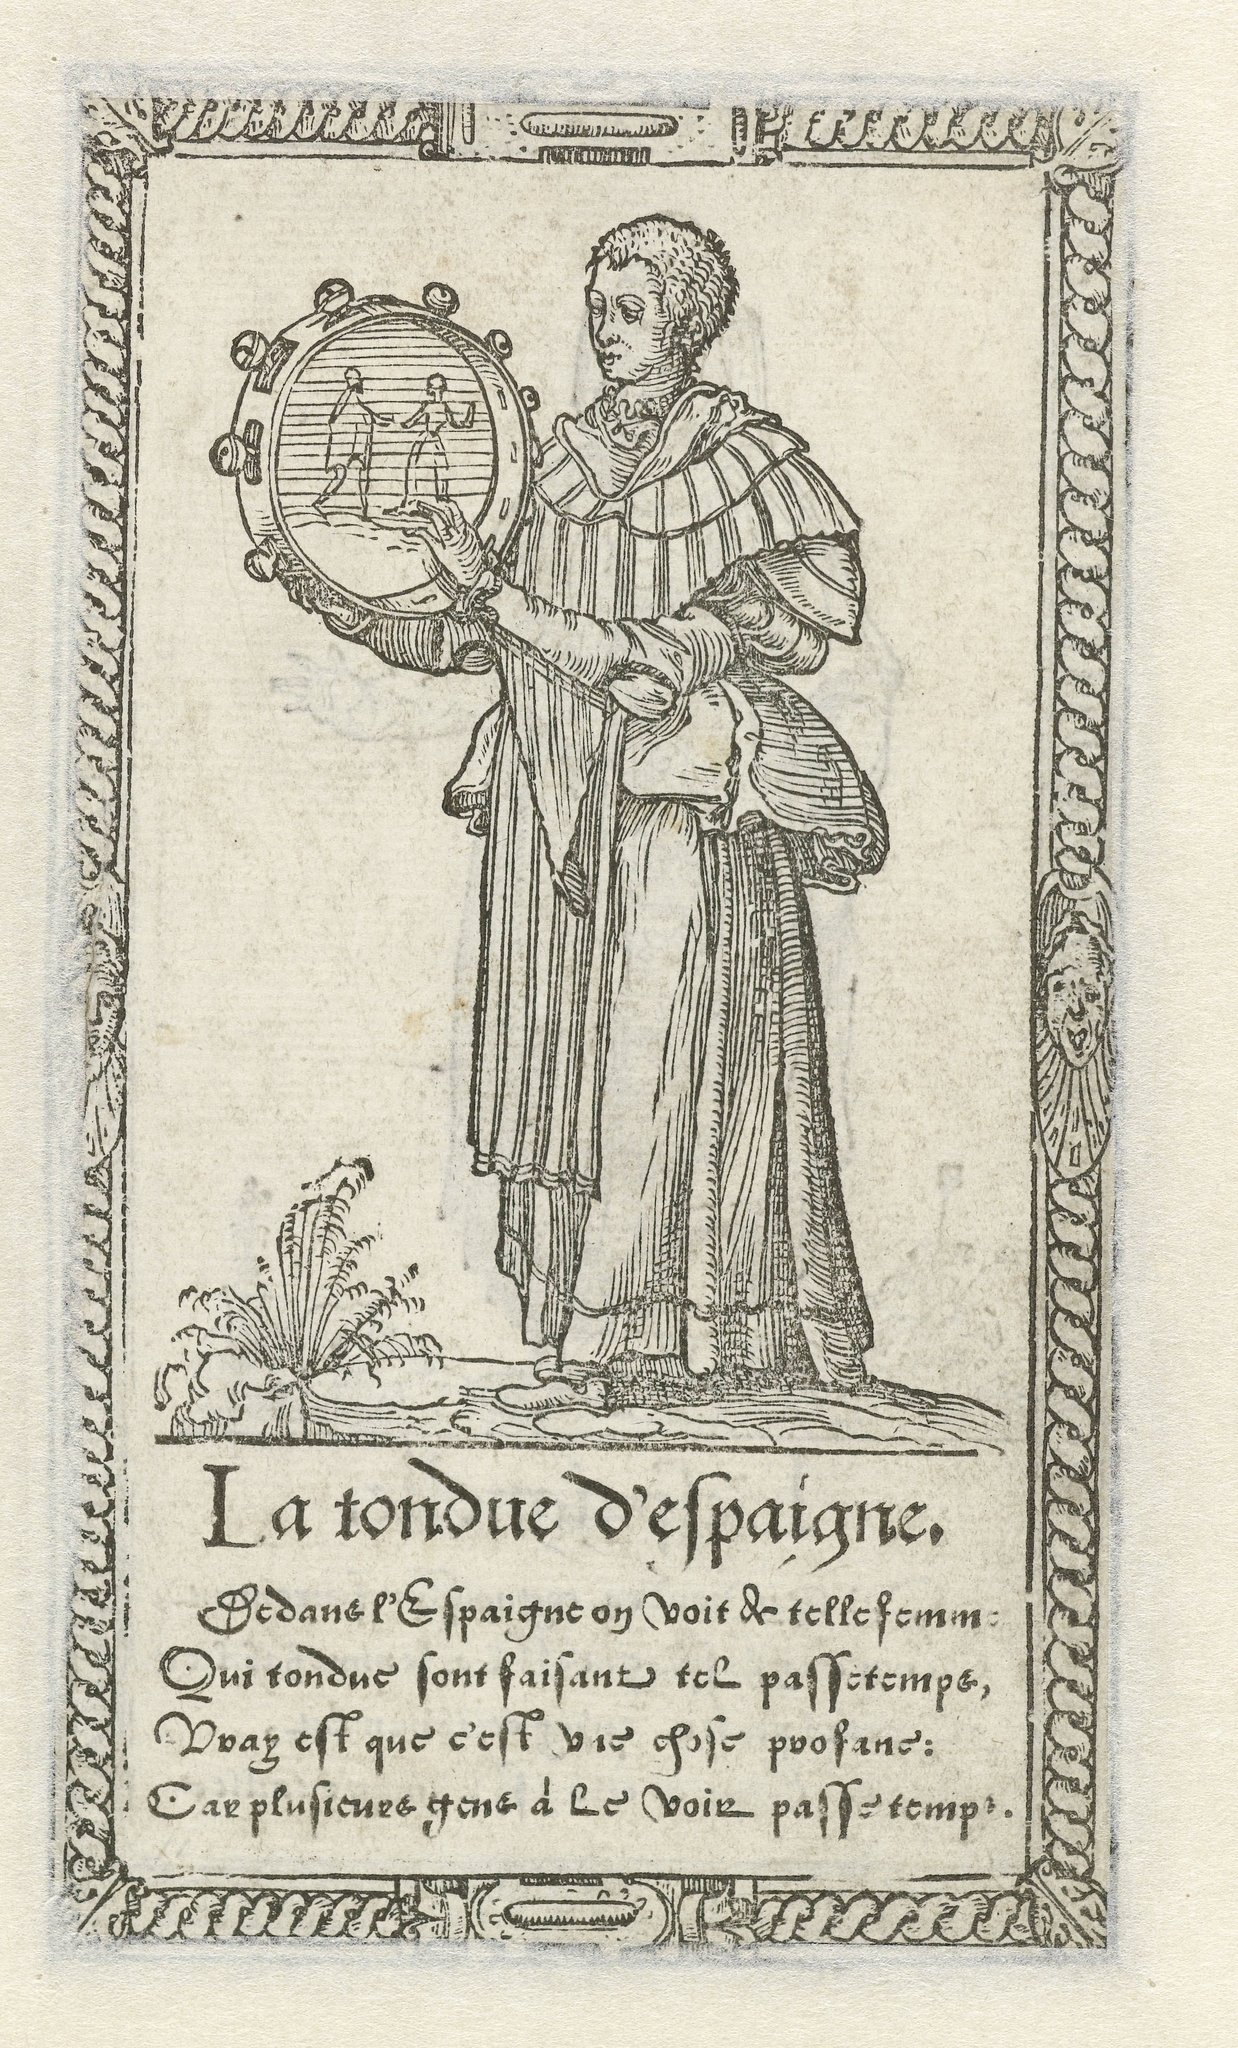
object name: print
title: Recueil de la diversité des habits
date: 1562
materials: paper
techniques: woodcut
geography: paris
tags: tambourine - cc - out of doors, europeans: spaniards (+ costume), fashion plates, folk costume, regional costume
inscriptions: collector's mark: Lugt 2228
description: Dit is prent 75 uit een serie van 121. Binnen deze serie zijn er prenten gemaakt naar voorbeelden van Jean-François de Roberval en Enea Vico, onbekend welke precies.